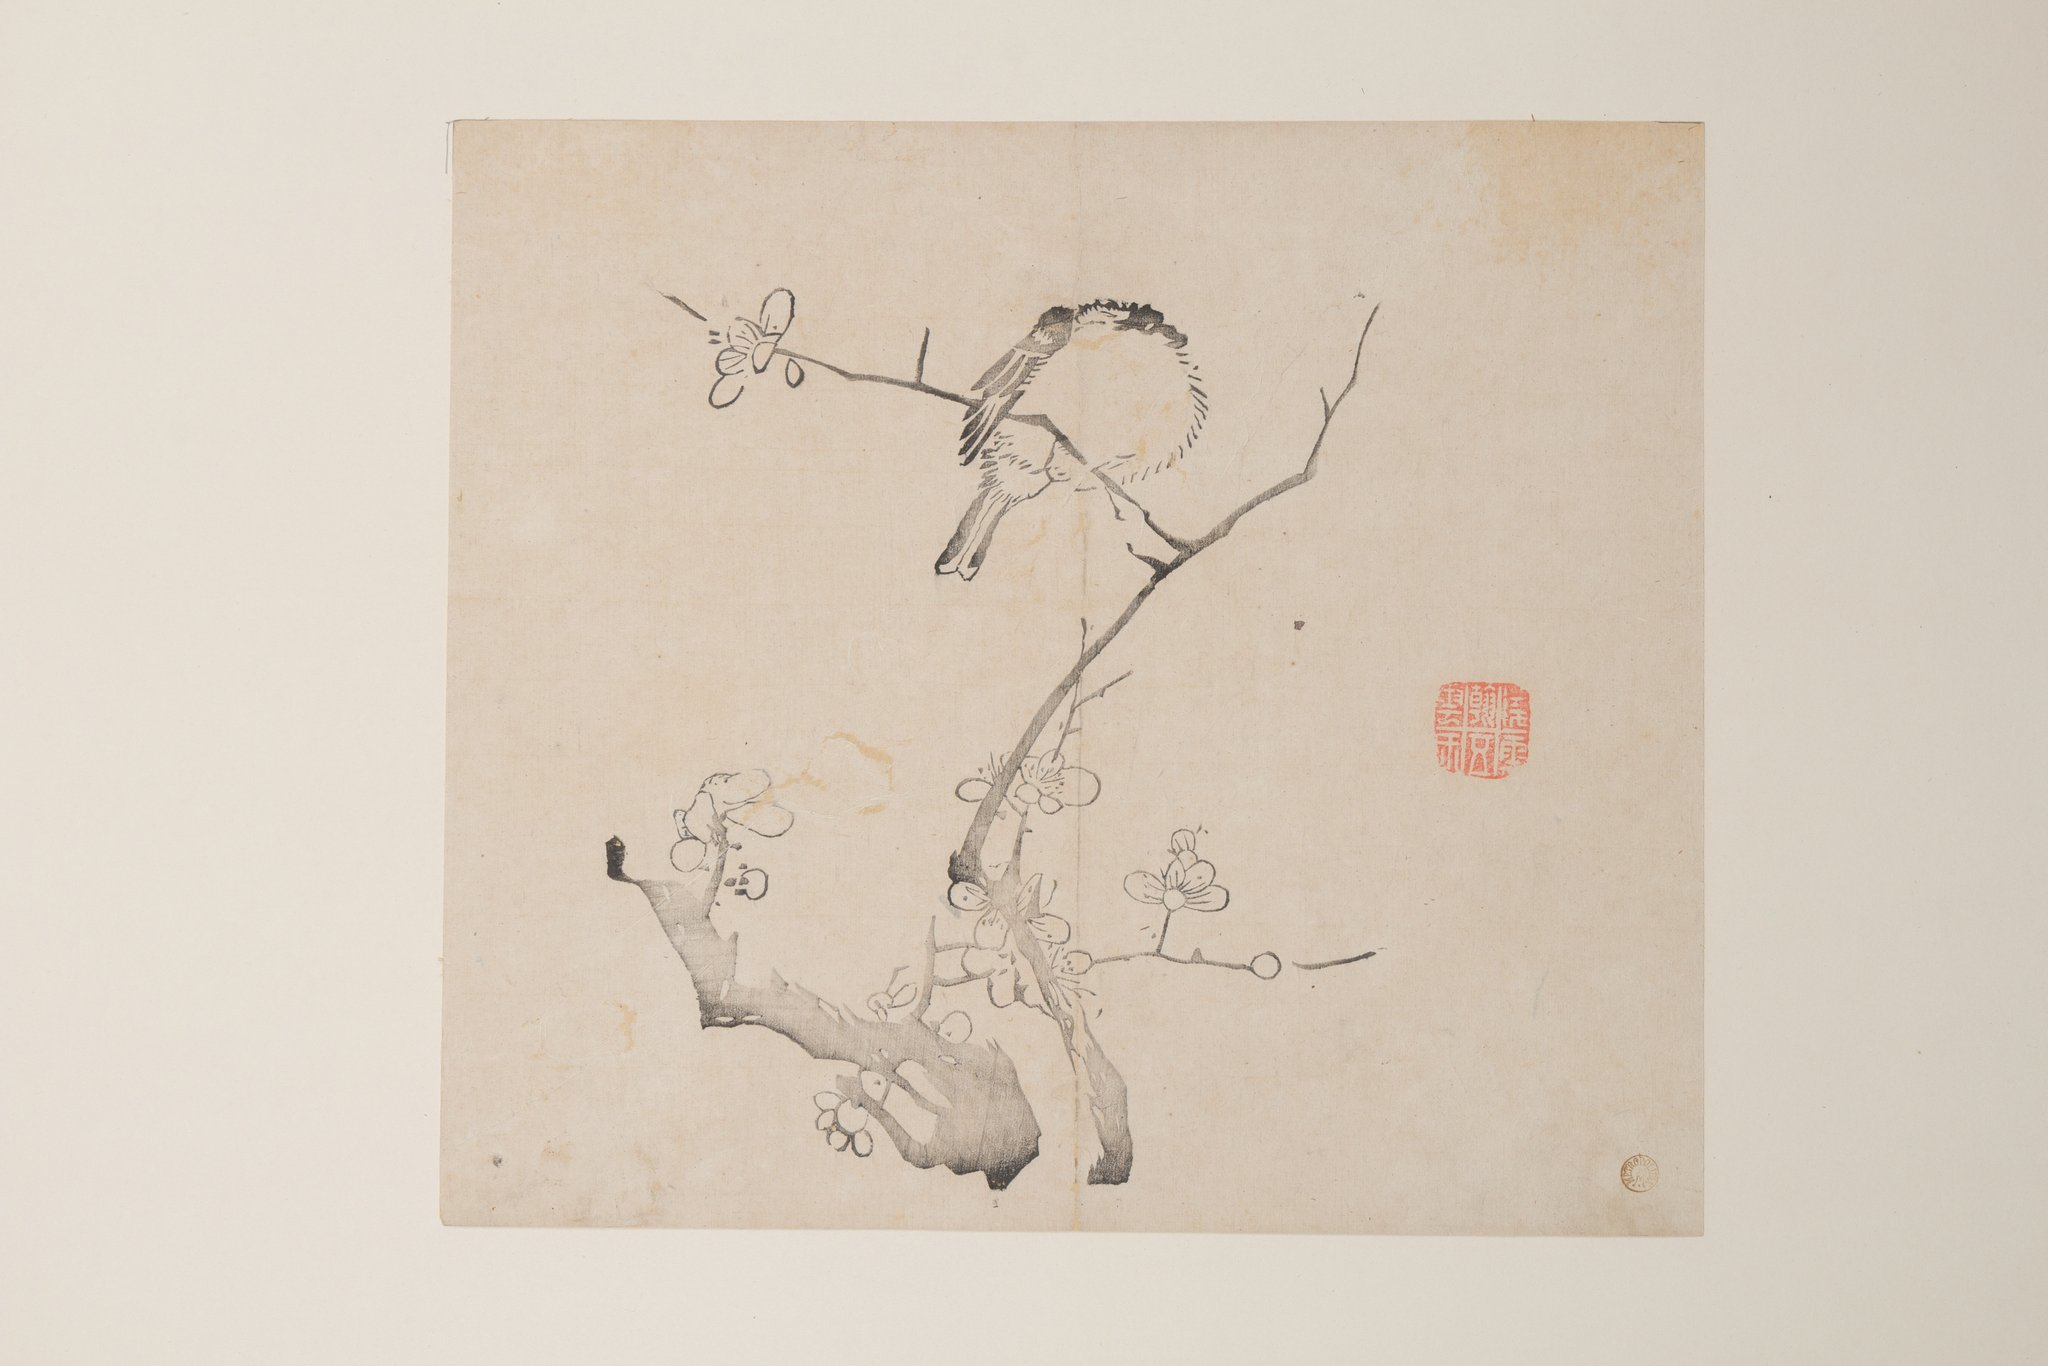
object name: print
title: Leaf from the Ten Bamboo Studio Manual of Painting and Calligraphy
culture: chinese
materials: ink, paper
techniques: printing